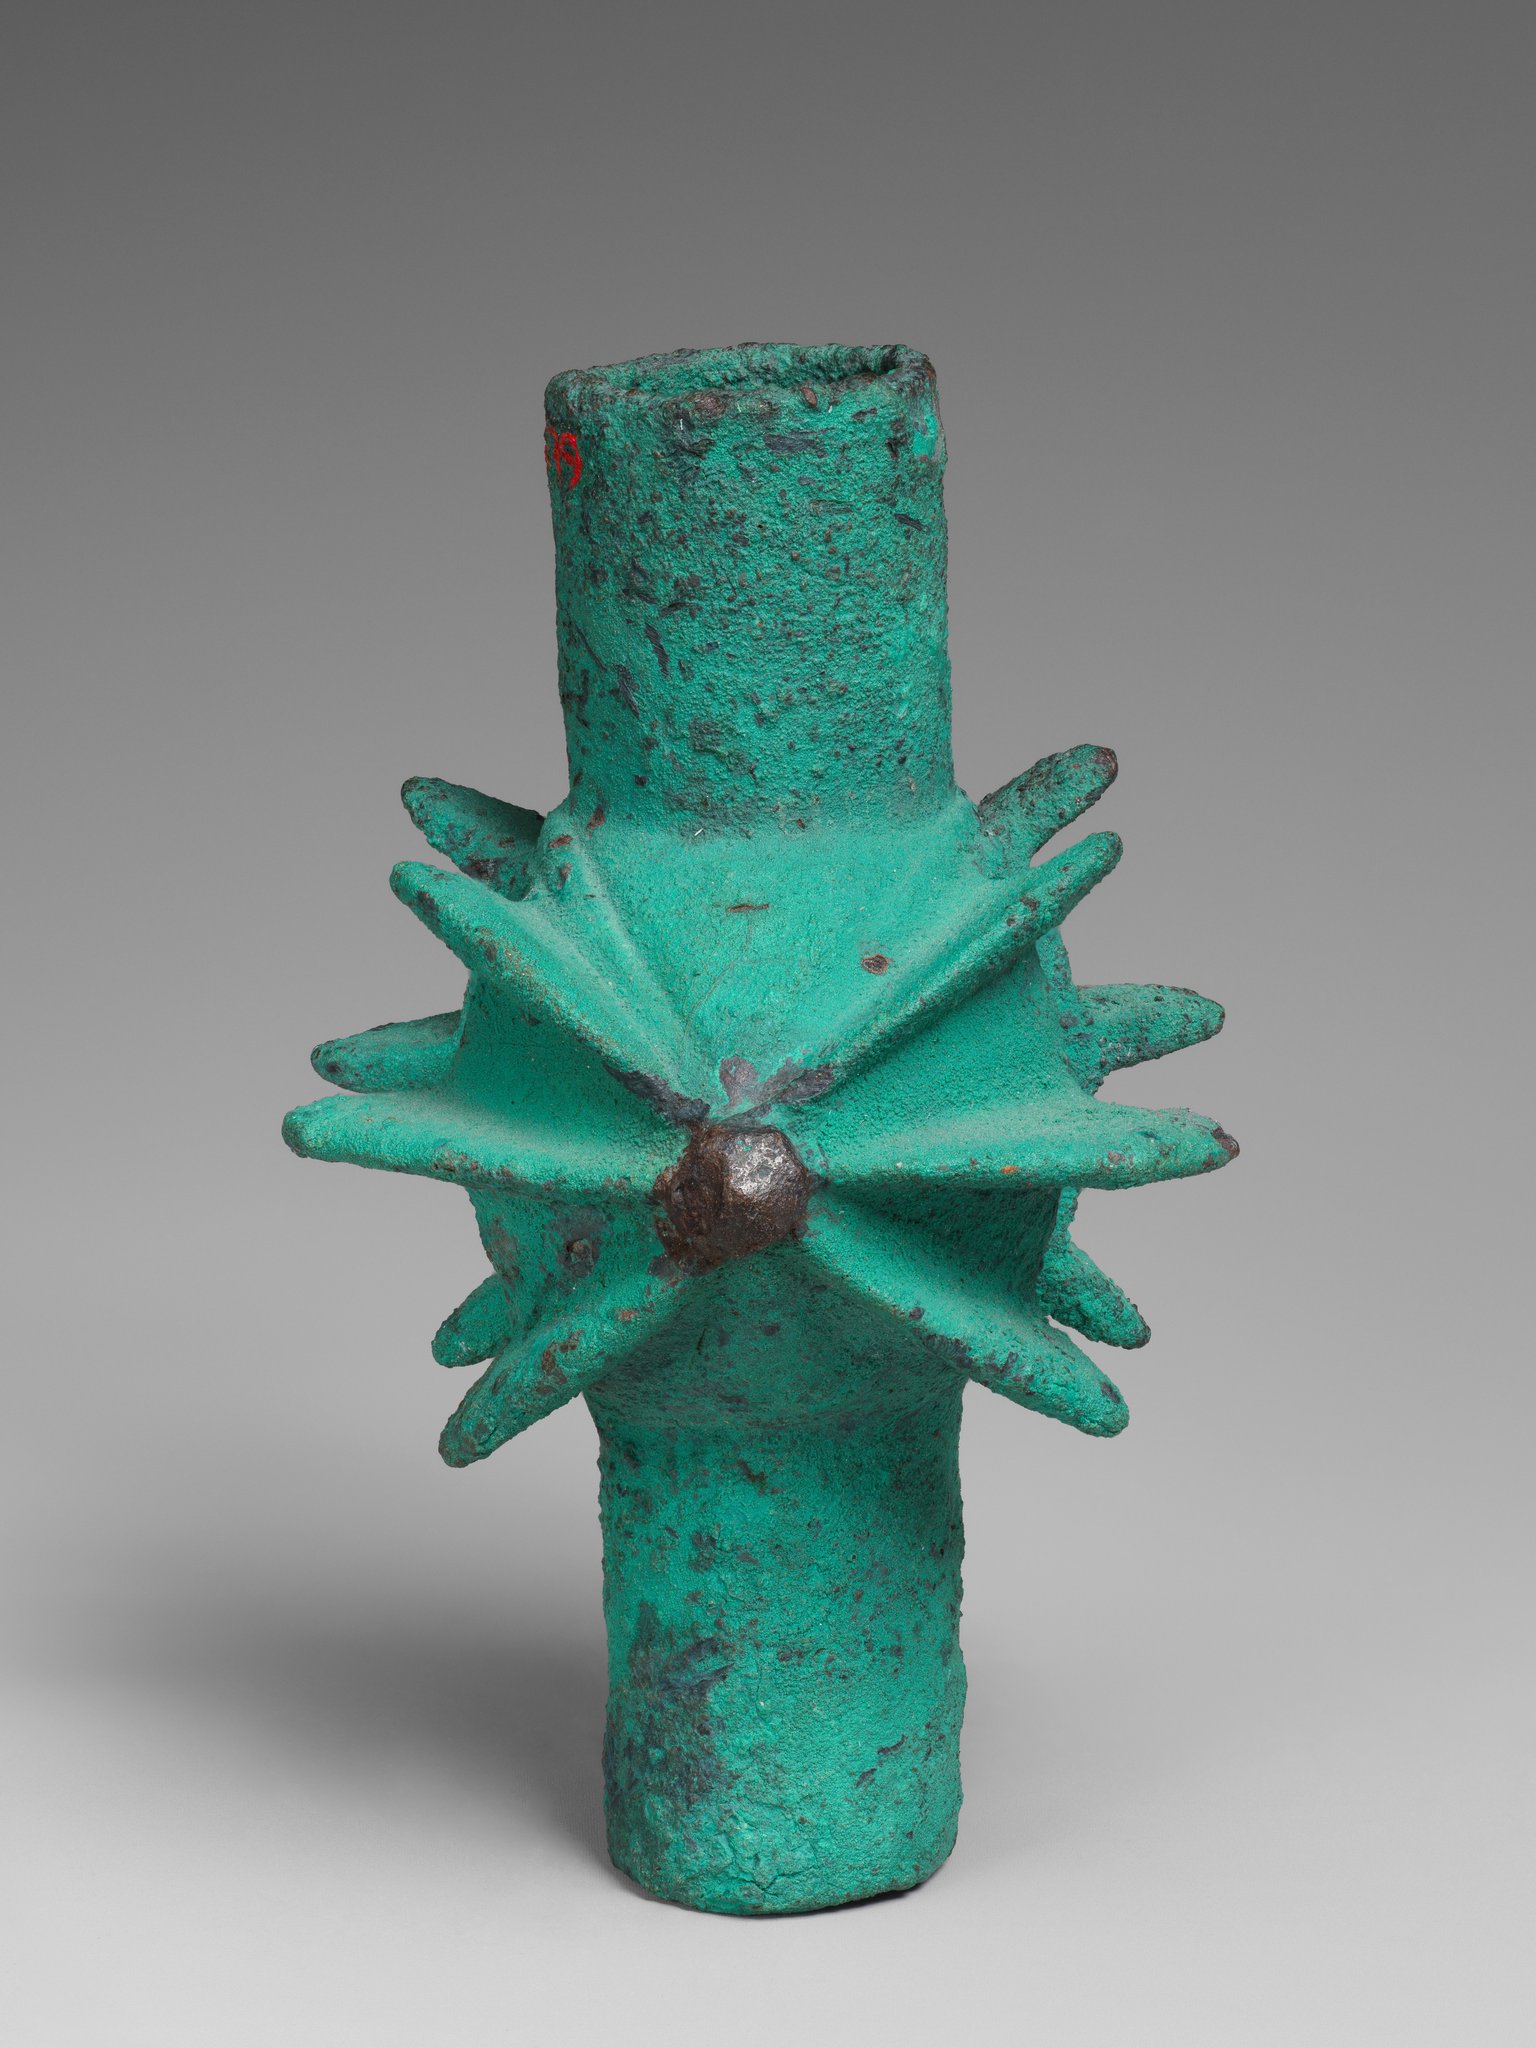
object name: mace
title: Mace head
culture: iranian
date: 900-801 BCE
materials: bronze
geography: iran